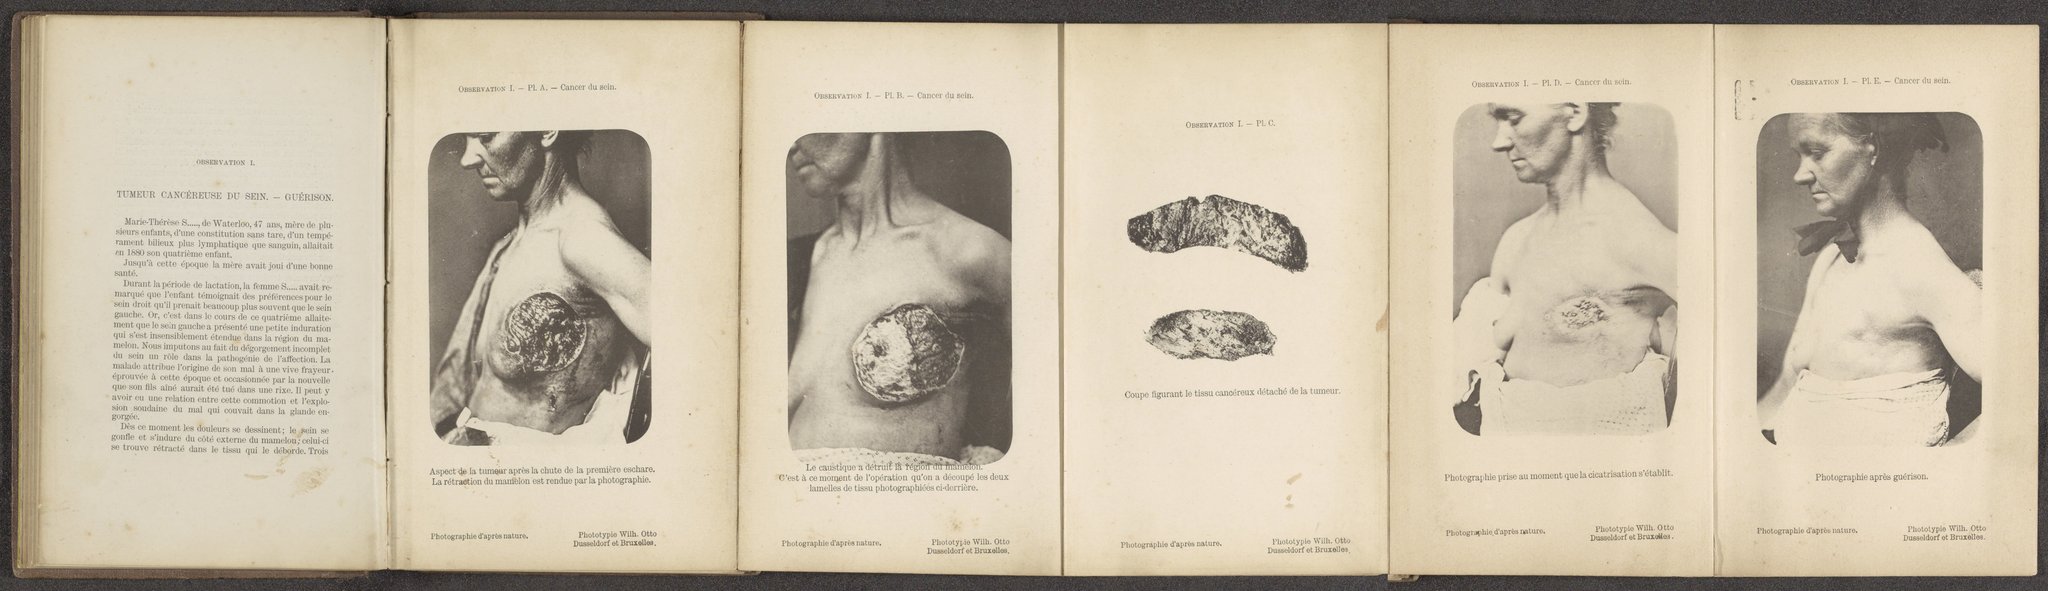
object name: photomechanical print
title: Vrouw met een hersteld litteken na het verwijderen van een borsttumor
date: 1874-1884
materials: paper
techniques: photograph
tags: tumours - aa - female human figure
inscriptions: inscription: ‘Observation I. - Pl. E. - Cancer du sein. / Photographie aprrès guérison.’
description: Onderdelen 2 tot en met 6 vormen een leporello.